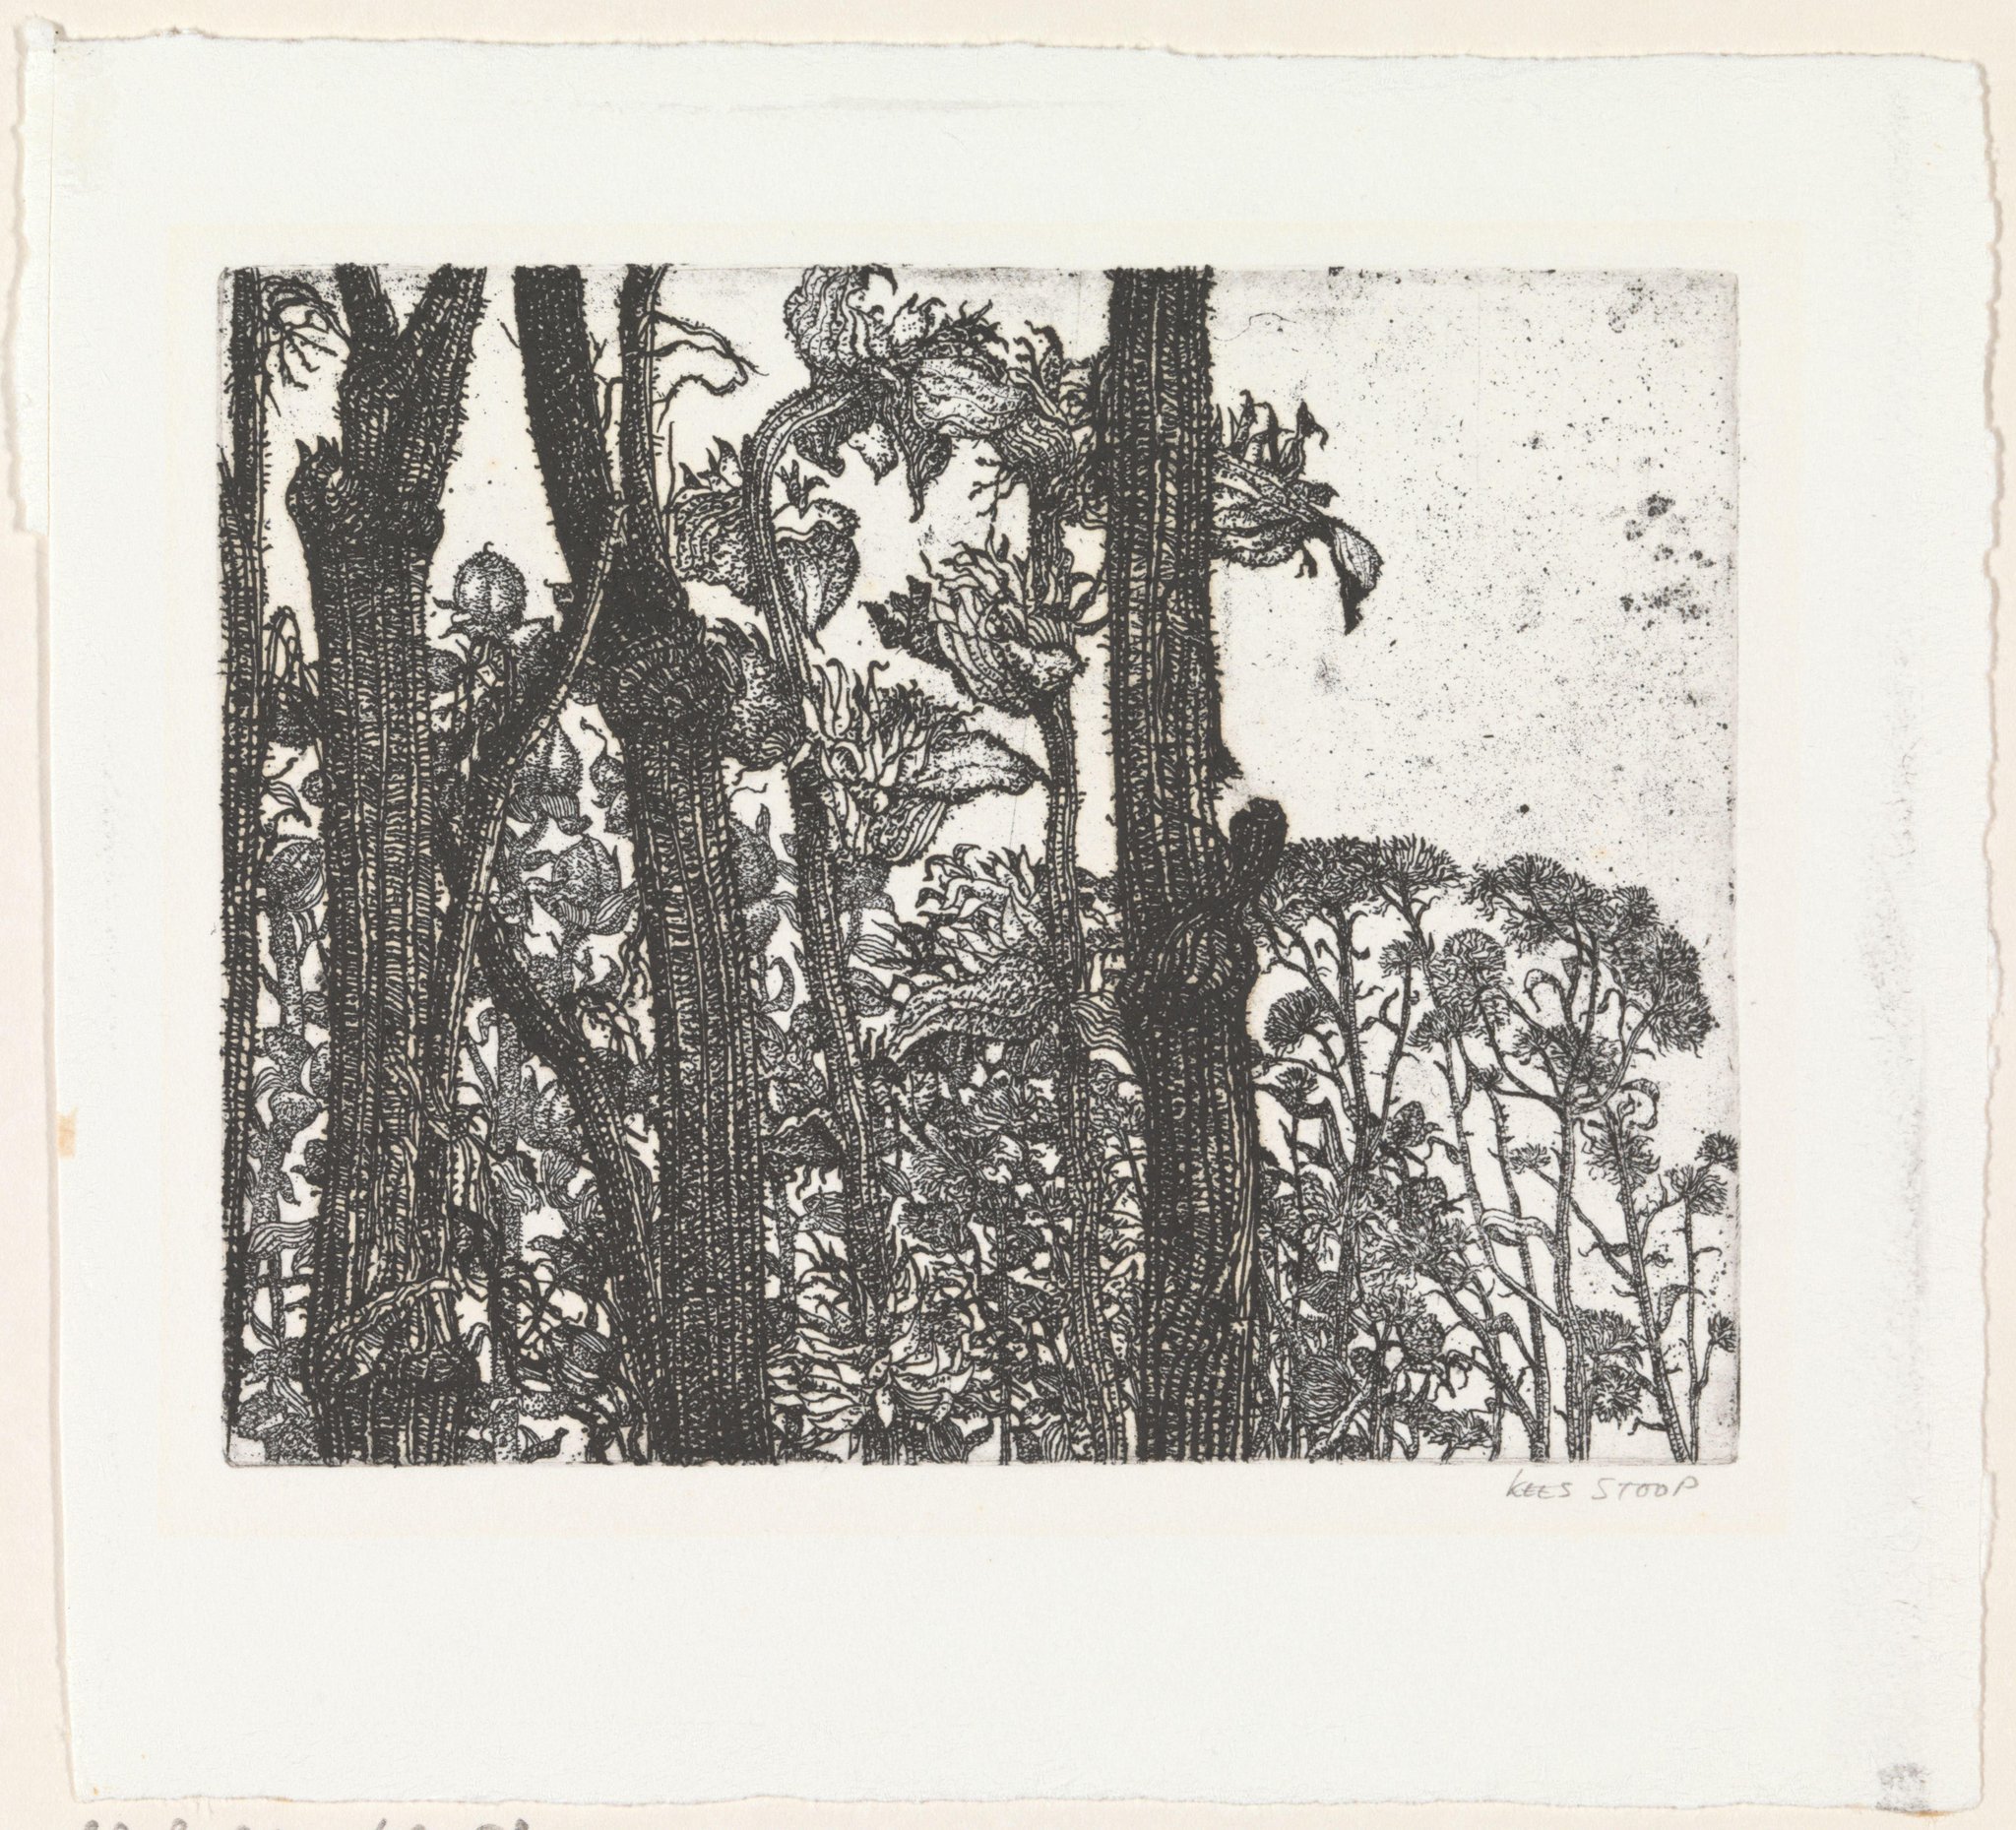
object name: print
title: Bloemstengels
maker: kees stoop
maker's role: draughtsman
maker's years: 1929-2019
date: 1970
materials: paper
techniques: etching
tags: flowers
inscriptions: signature: ‘KEES STOOP’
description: Bloemstengels met verticale banen op de voorgrond, bloemen op de achtergrond.